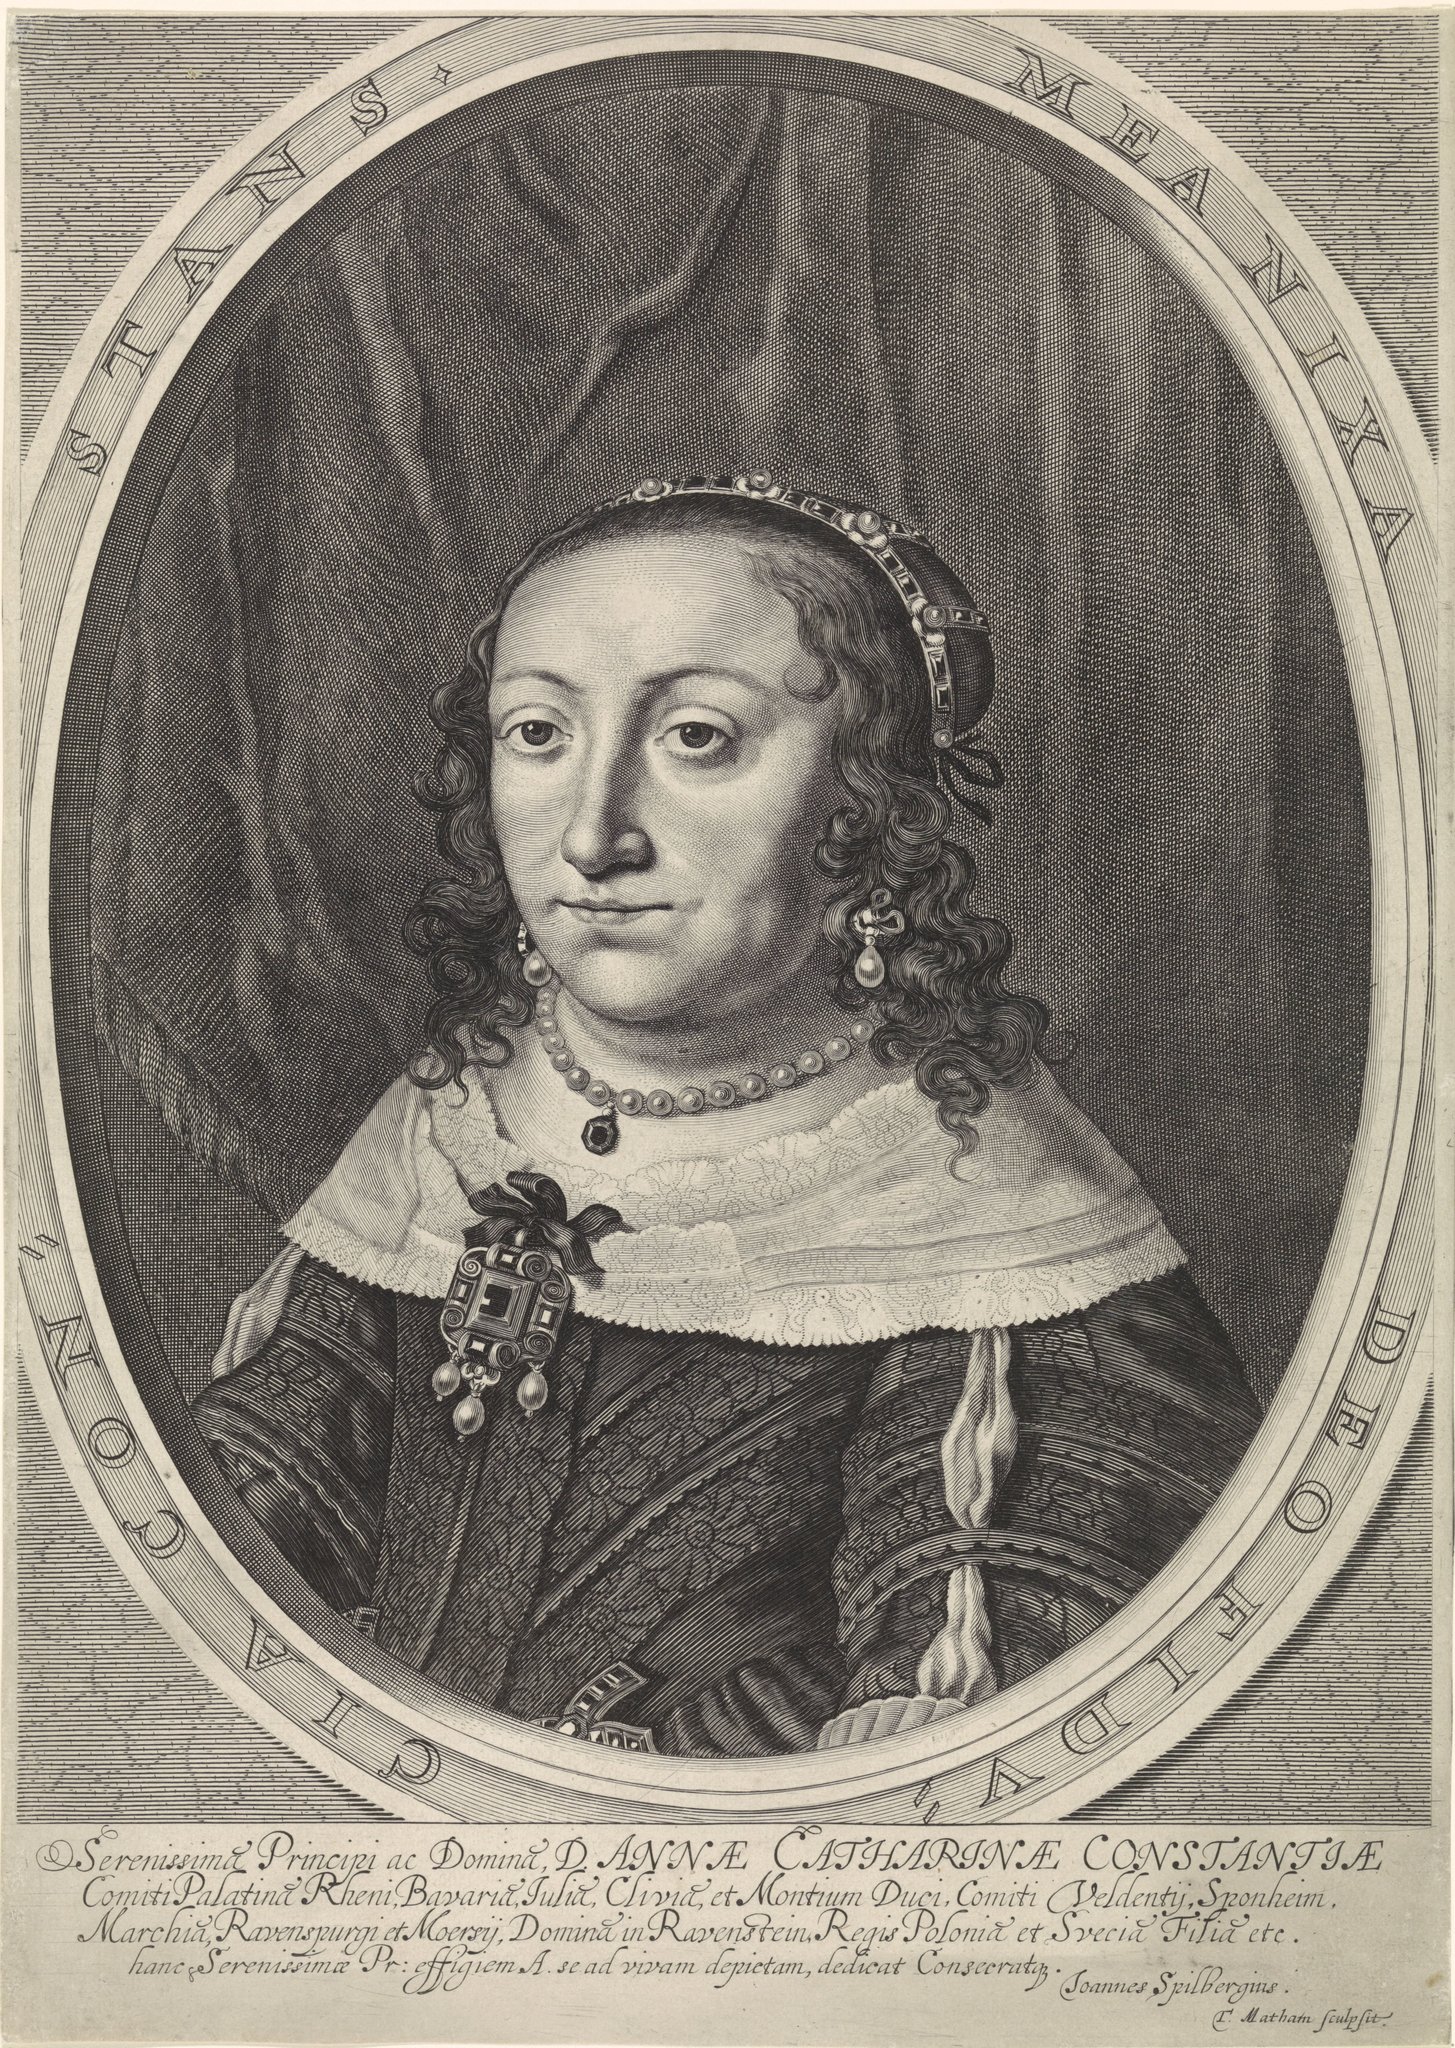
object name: print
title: Portret van Anna Catharina Constance, paltsgravin van Palts-Neuburg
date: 1635-1653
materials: paper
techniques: engraving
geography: northern netherlands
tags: ear-rings (+ women's clothes), brooch, agraffe, clasp (+ women's clothes), necklace (+ women's clothes)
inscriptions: collector's mark: Lugt 2228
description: Portret van Anna Catharina Constance, paltsgravin van Palts-Neuburg, dochter van Wolfgang Willem van de Palts-Neuburg en zijn tweede vrouw Catharina Charlotta. Om haar hals een parelsnoer met een hanger.